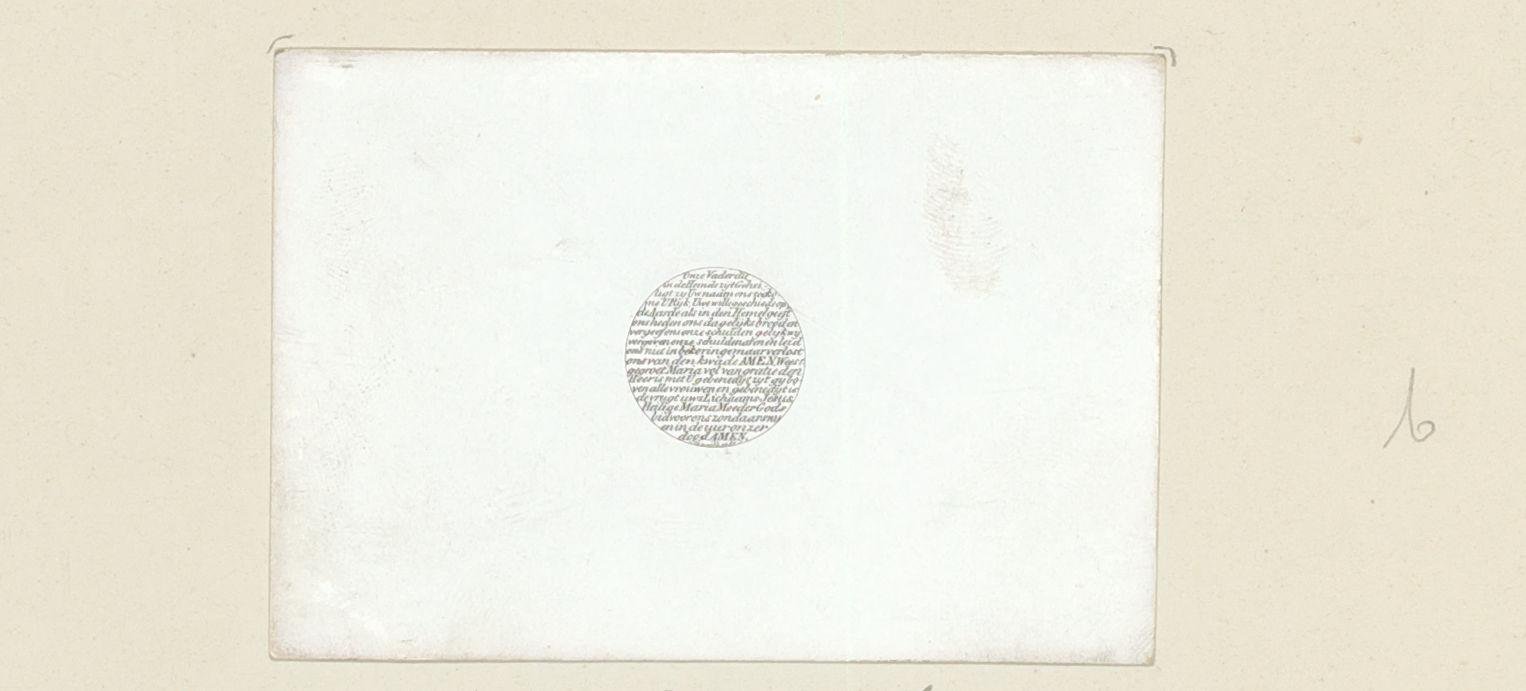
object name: print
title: Adreskaart van Leonardus Schweickhardt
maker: leonardus schweickhardt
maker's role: print maker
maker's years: 1783-1862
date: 1793-1862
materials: porcelainized cardboard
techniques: engraving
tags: the hague, leonardus schweickhardt, 'our father which art in heaven' ~ the lord's prayer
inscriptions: collector's mark: Lugt 1641, stamp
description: In een kleine cirkel (diameter ca. 15 millimeter) is het Onzevader gegraveerd, met daarbij: 'L. Schweickhardt Kunst Graveur 's Gravenhage'. Onderwerpsrubrieken binnen de Atlas Zeden en Gewoonten: Godsdienst, Roomsch-Katholieken, Processies, Herinneringen.